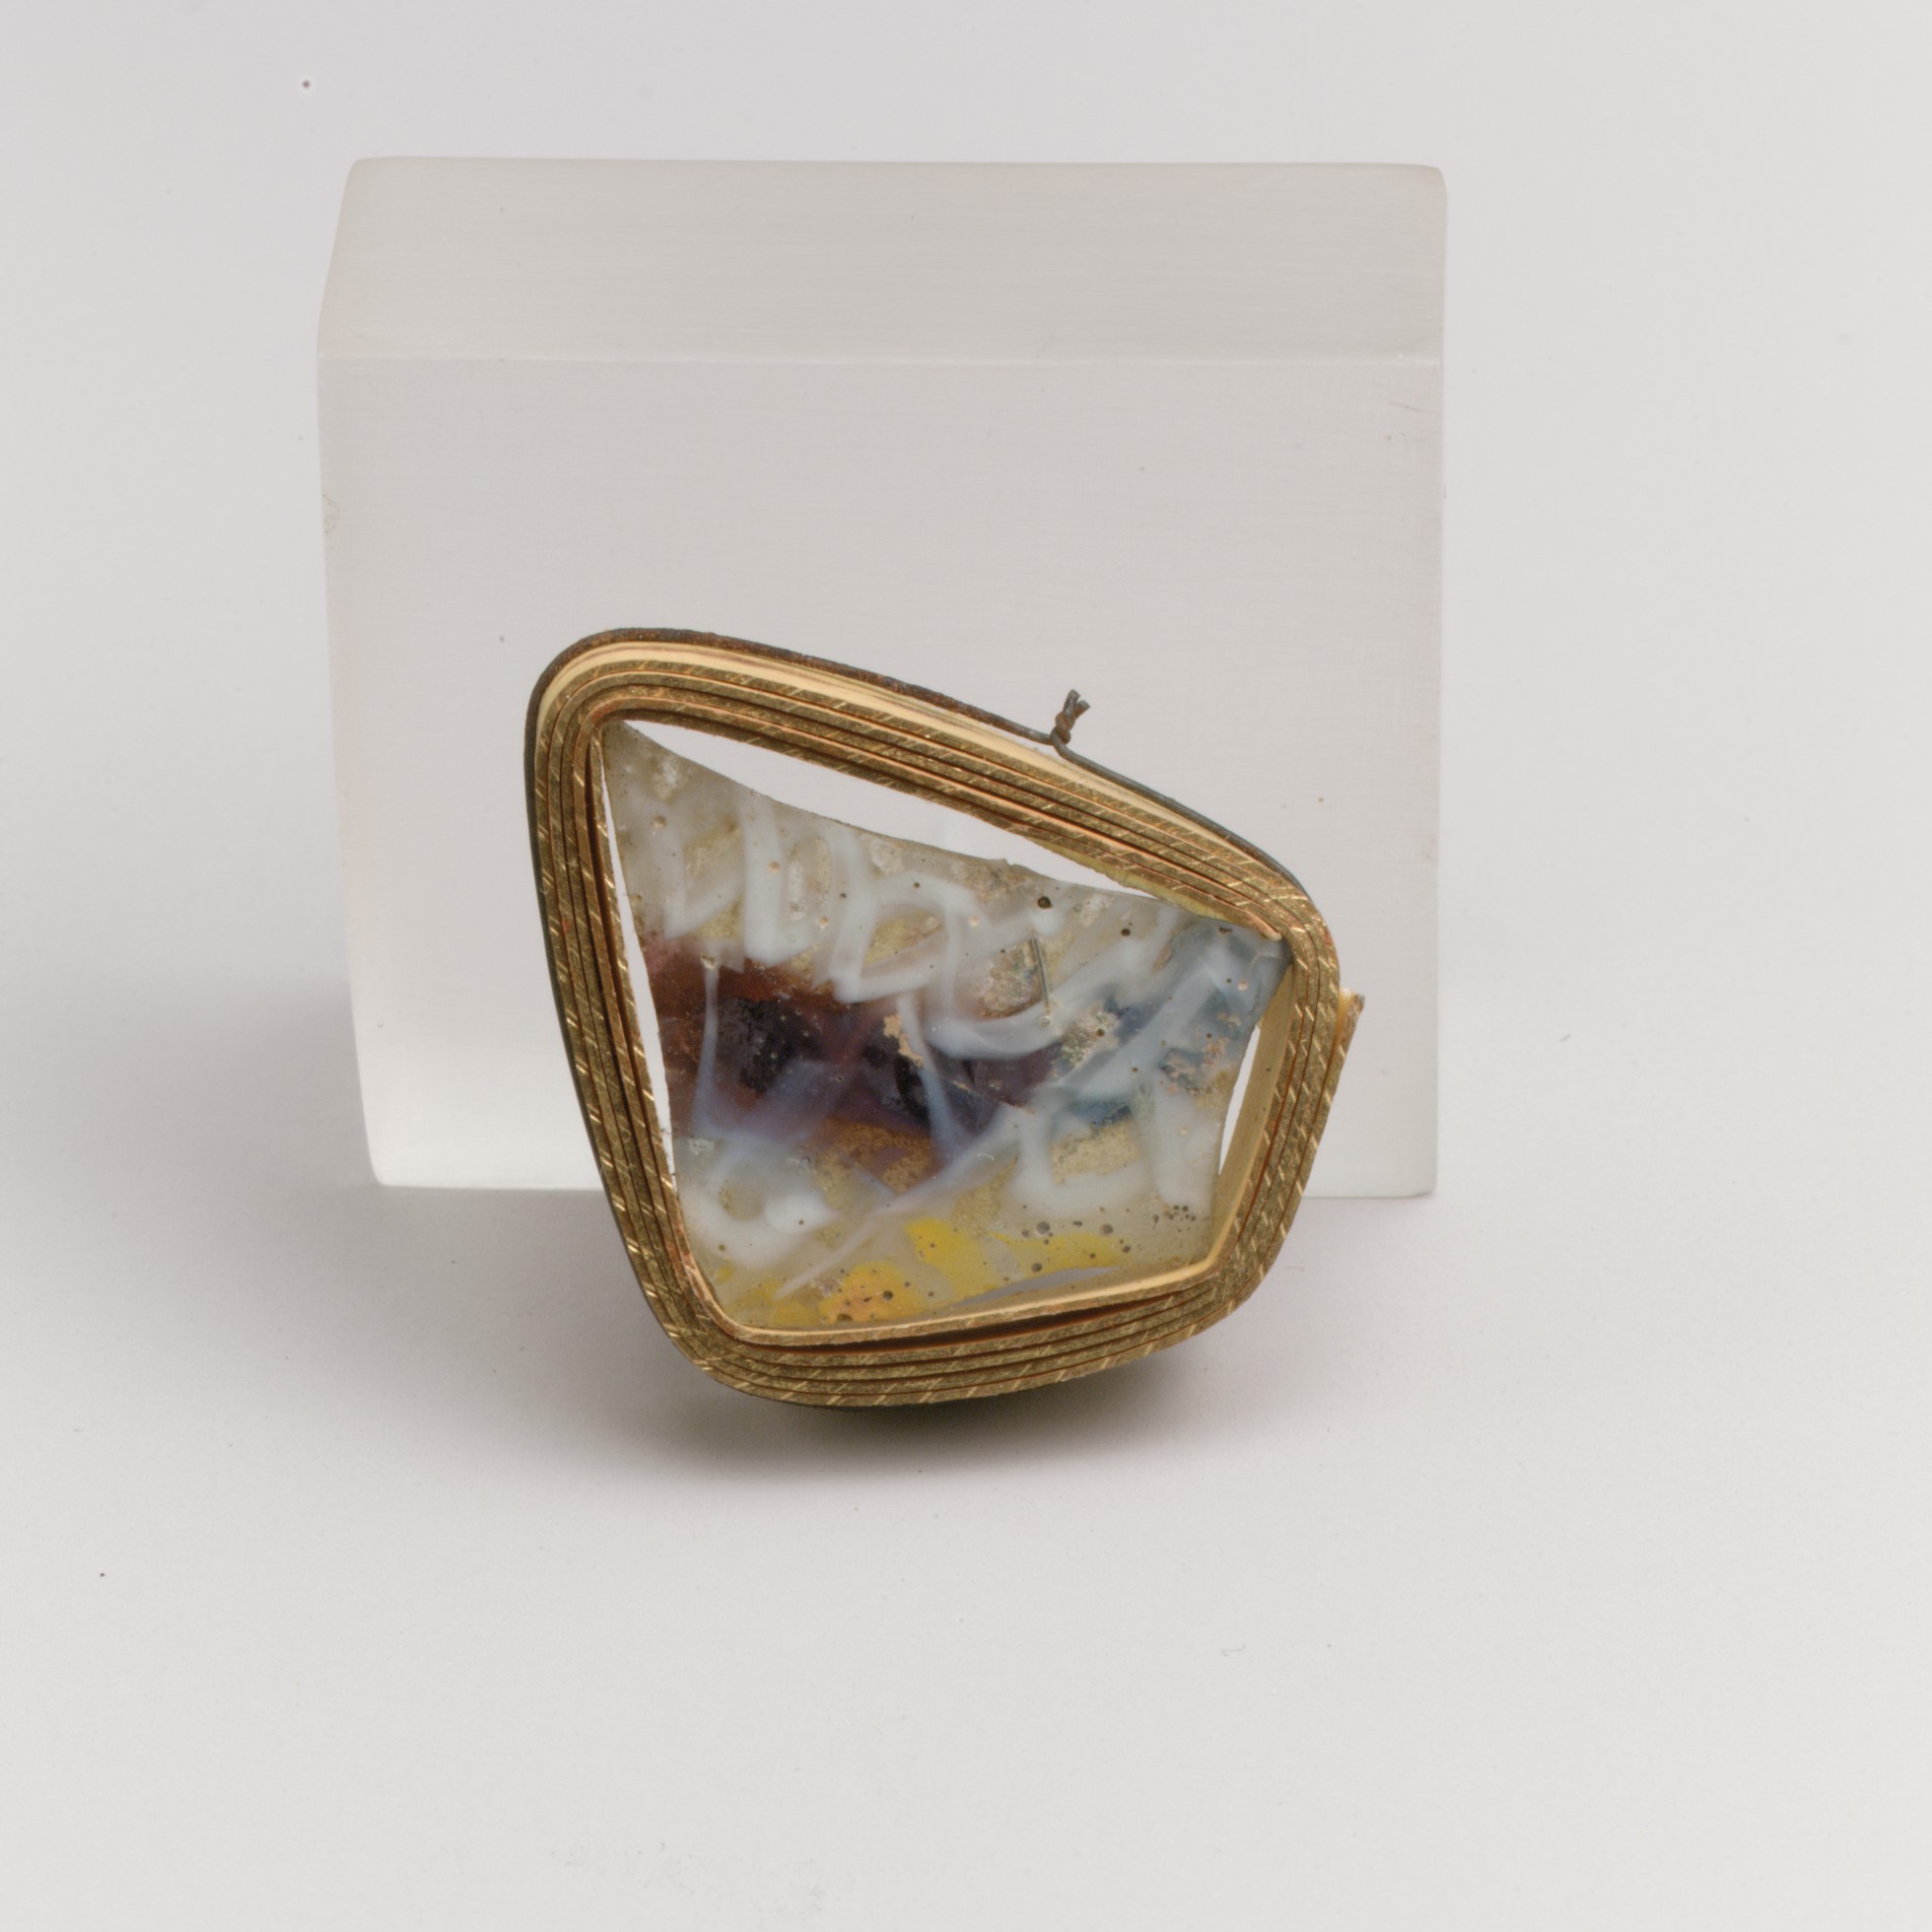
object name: fragment, mosaic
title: Glass mosaic fragment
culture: roman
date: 34 BCE-33 CE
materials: glass